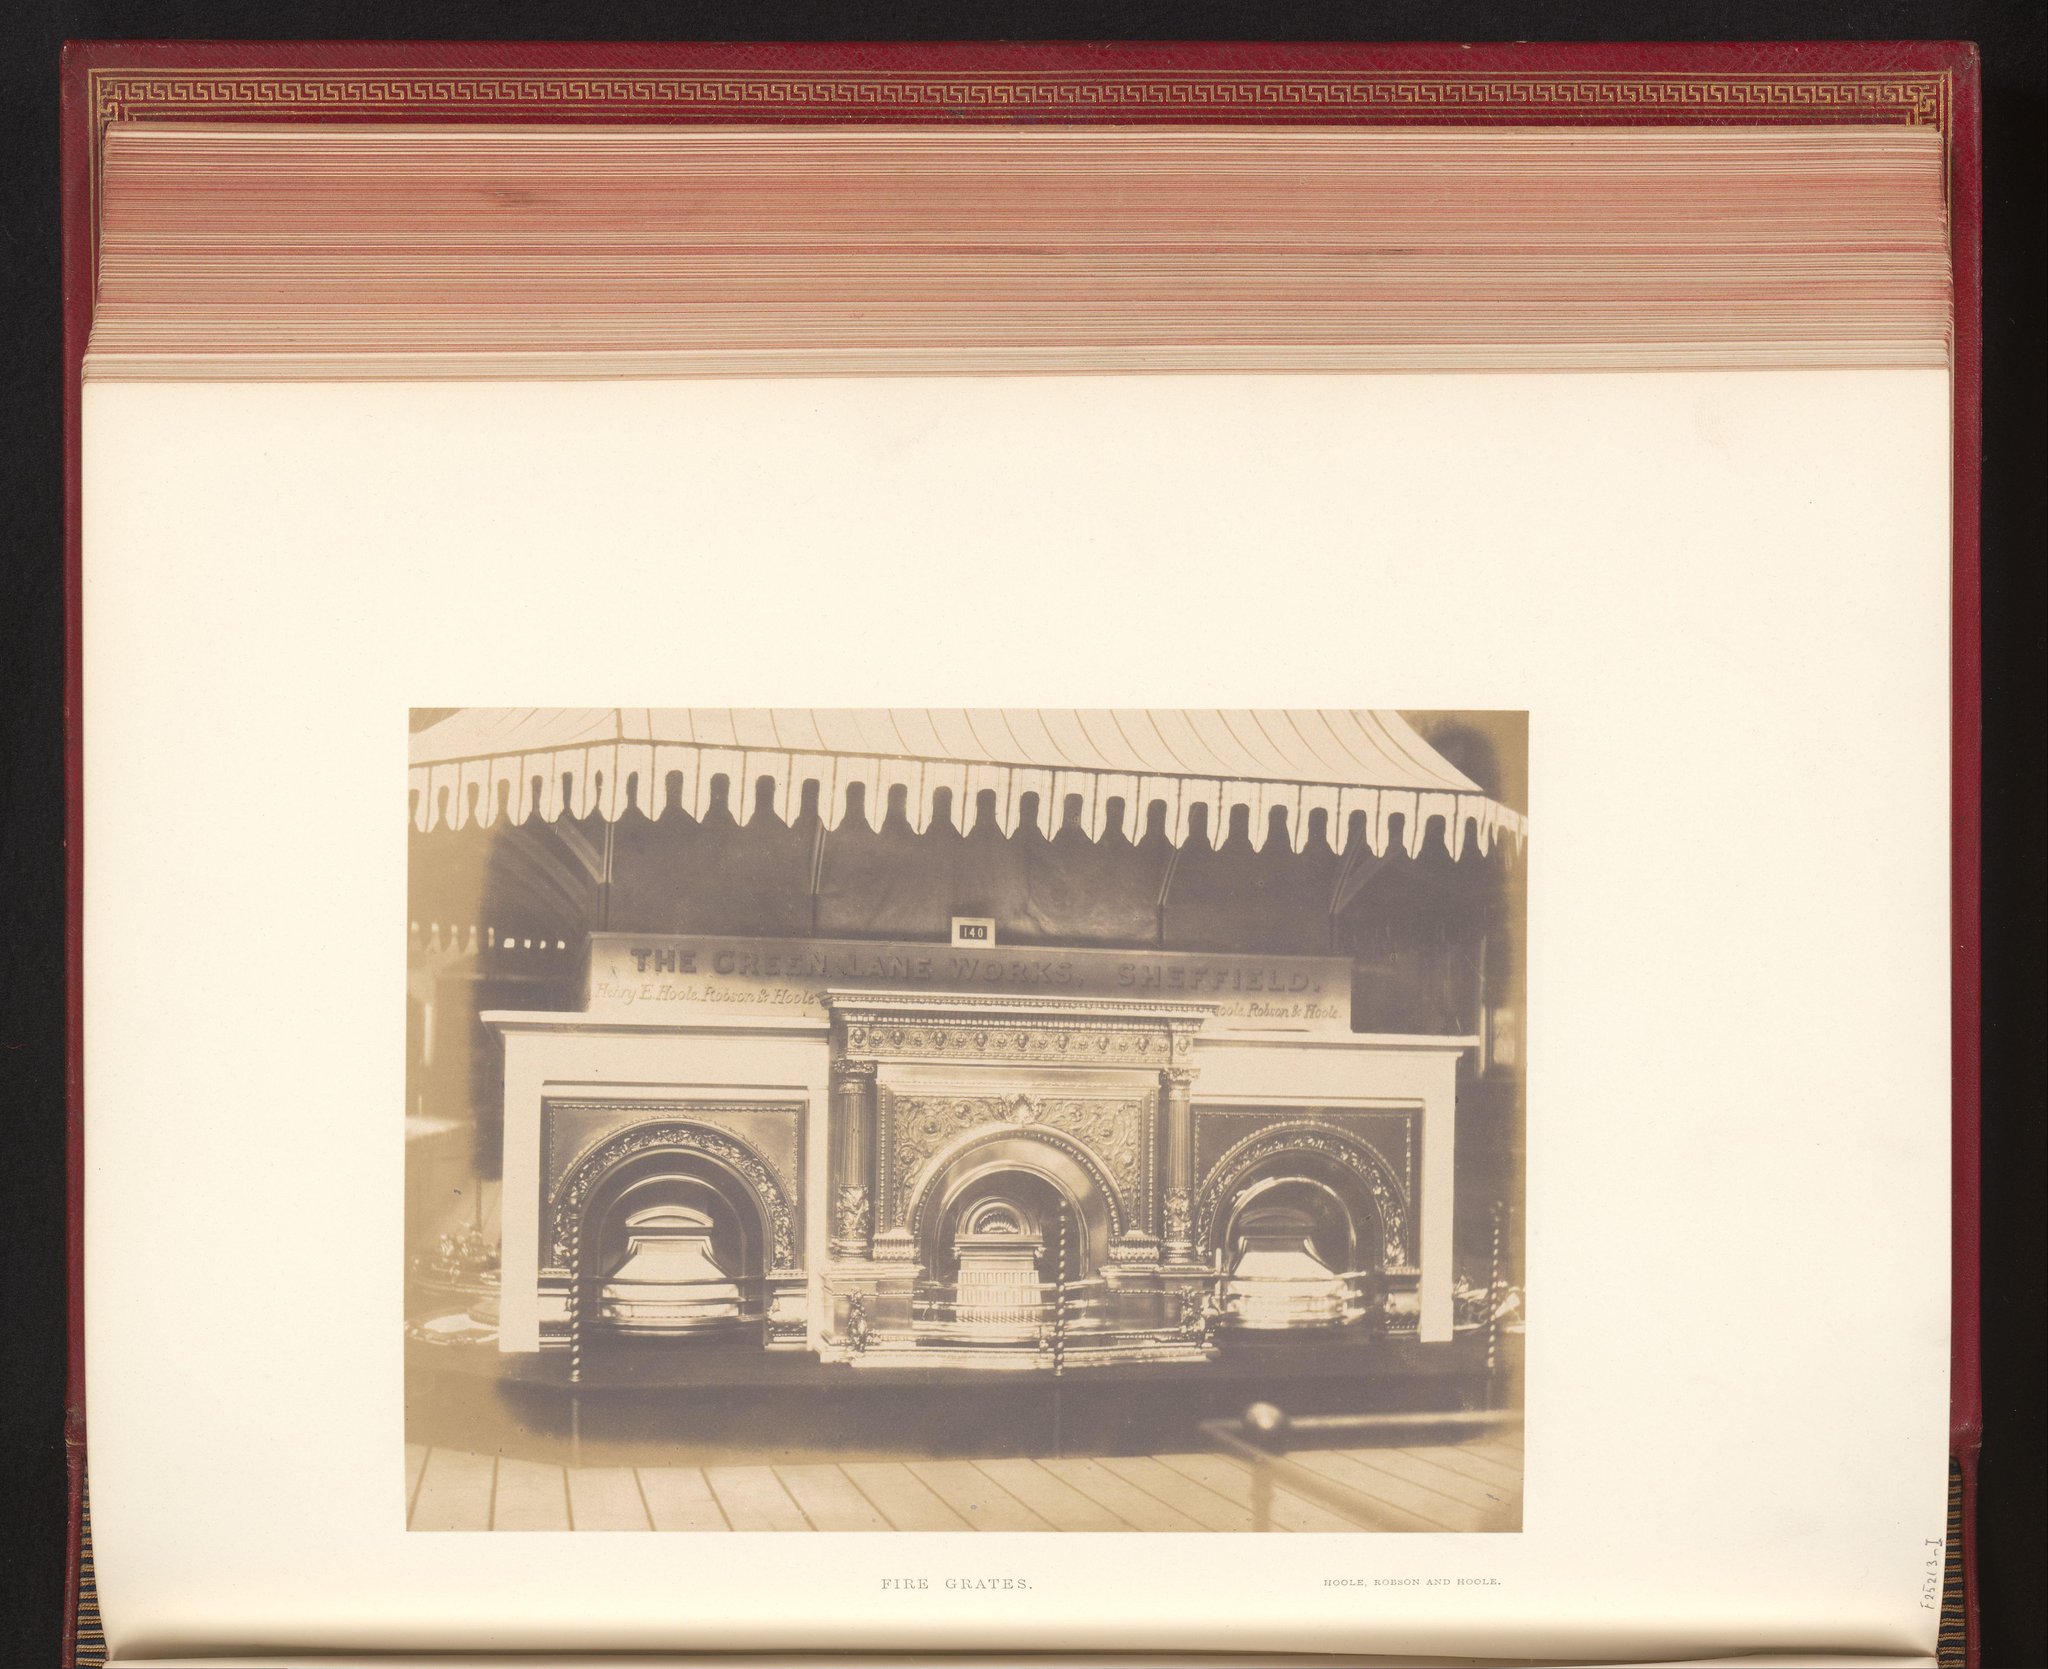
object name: photograph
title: Openhaarden van Hoole en Robson and Hoole tentoongesteld op de Great Exhibition of the Works of Industry of All Nations van 1851 in Londen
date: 1851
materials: photographic support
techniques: salted paper print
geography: london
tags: open hearth, fire-place, london